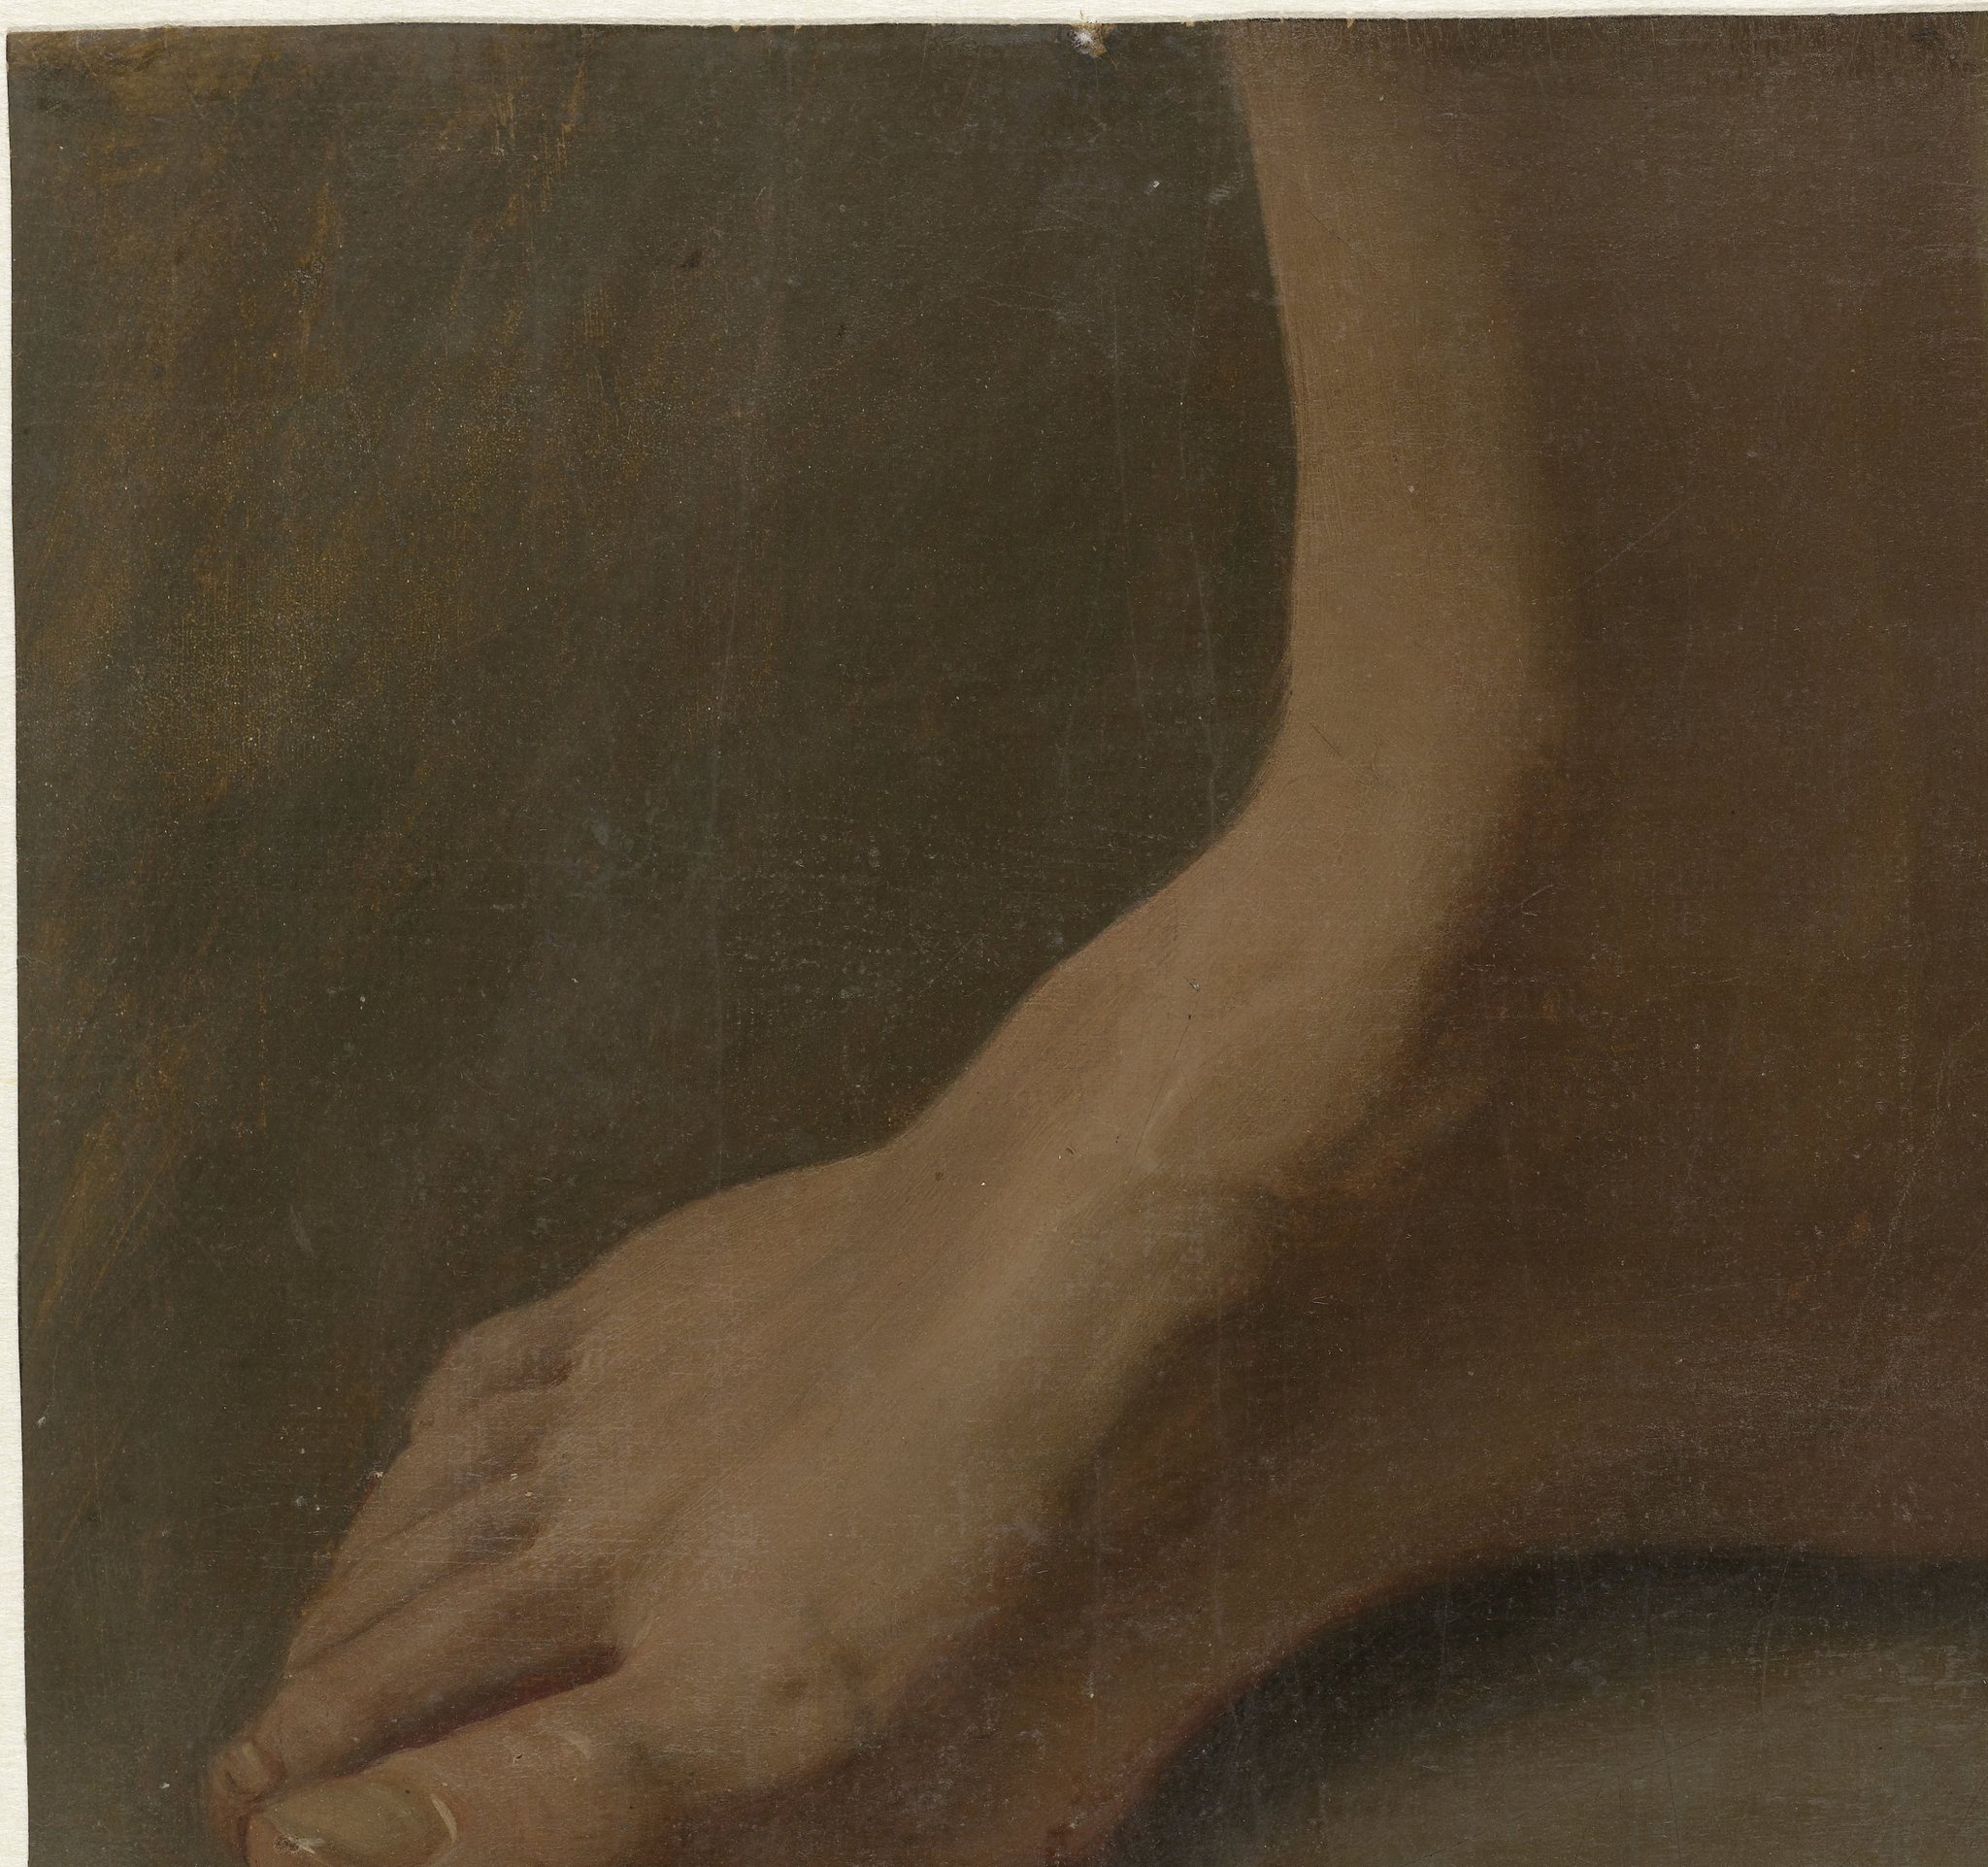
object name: painting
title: A Right Foot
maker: simon andreas krausz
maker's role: draughtsman, print maker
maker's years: 1760-1825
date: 1770-1825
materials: linen, oil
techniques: brush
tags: foot